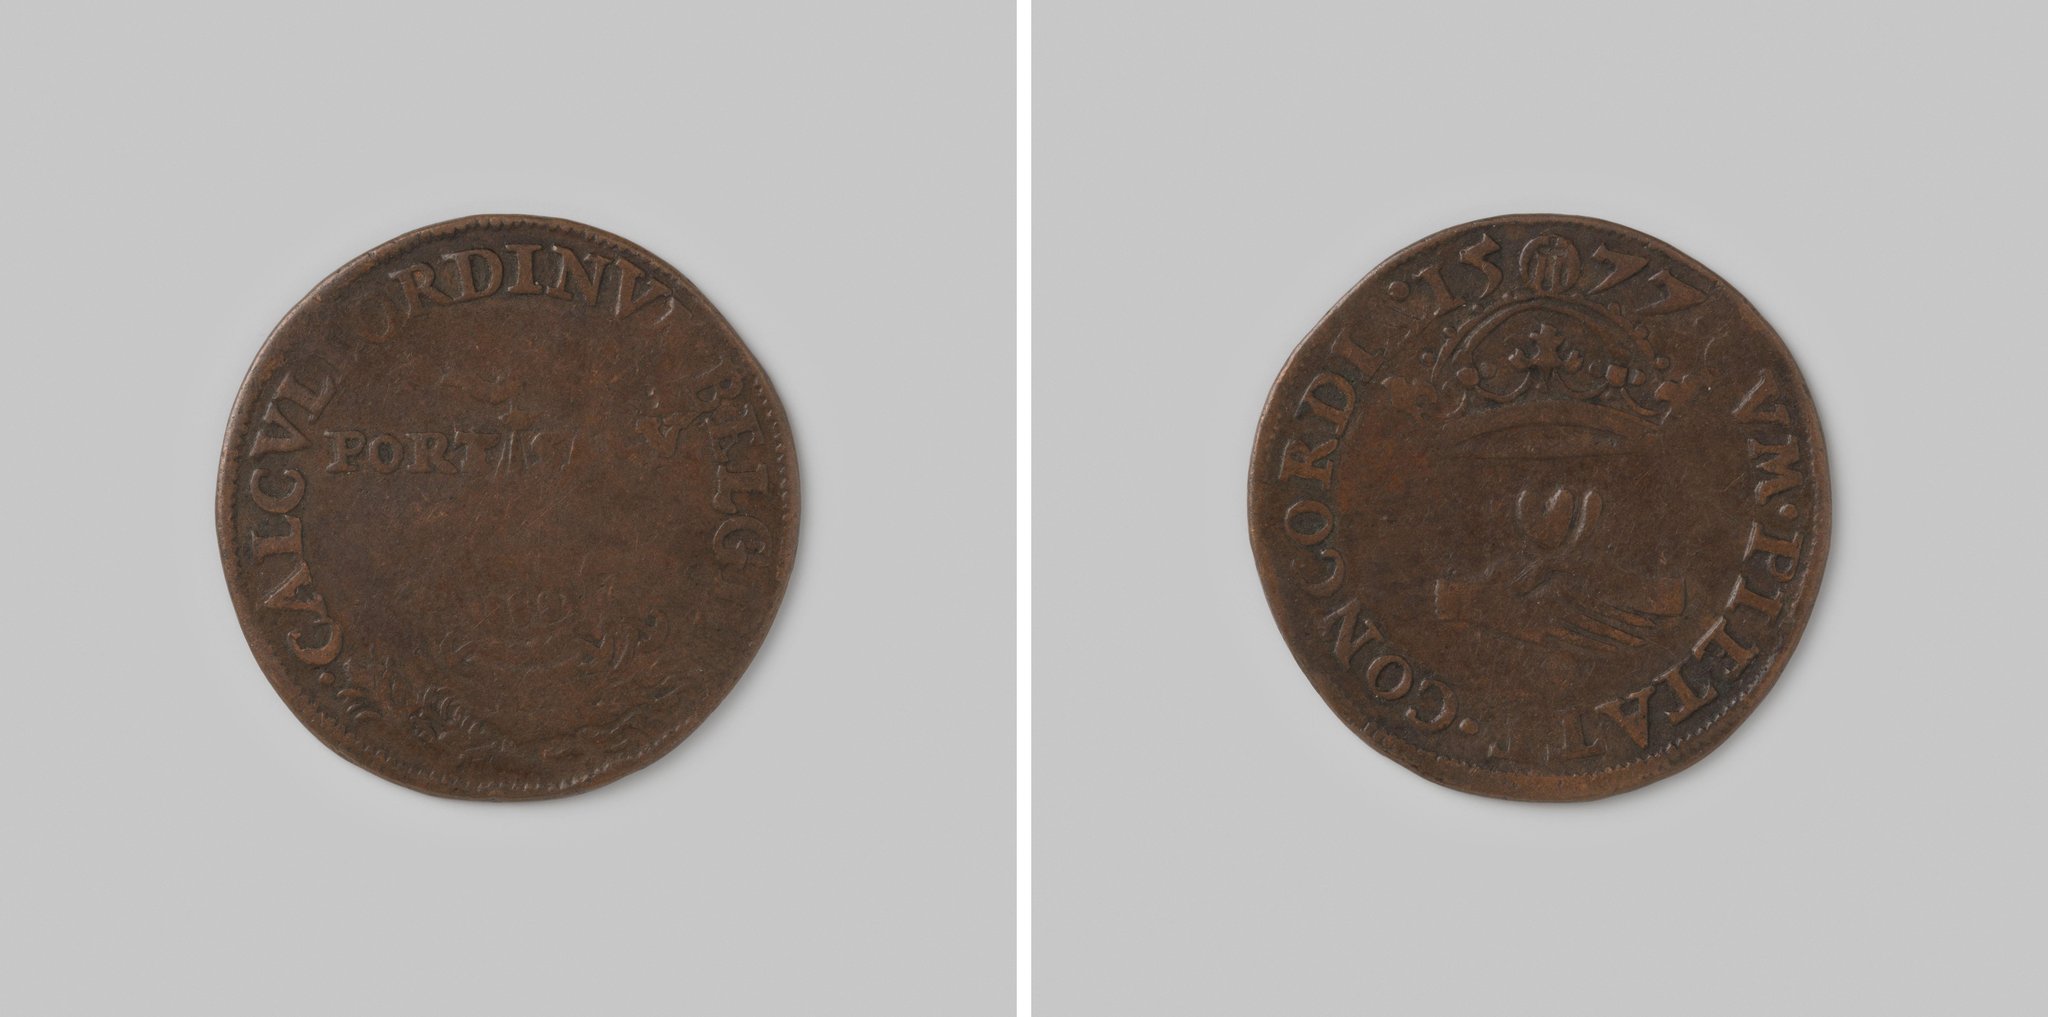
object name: history medal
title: Rekenpenning voor de Nederlandse Staten op de vredesonderhandelingen 1577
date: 1577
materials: copper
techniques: striking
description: Koperen penning, op de voorzijde een schip gereed tot ankeren, met één regel tekst in het veld en omschrift, op de keerzijde onder een kroon twee ineengedrukte handen met drie harten, met omschrift.